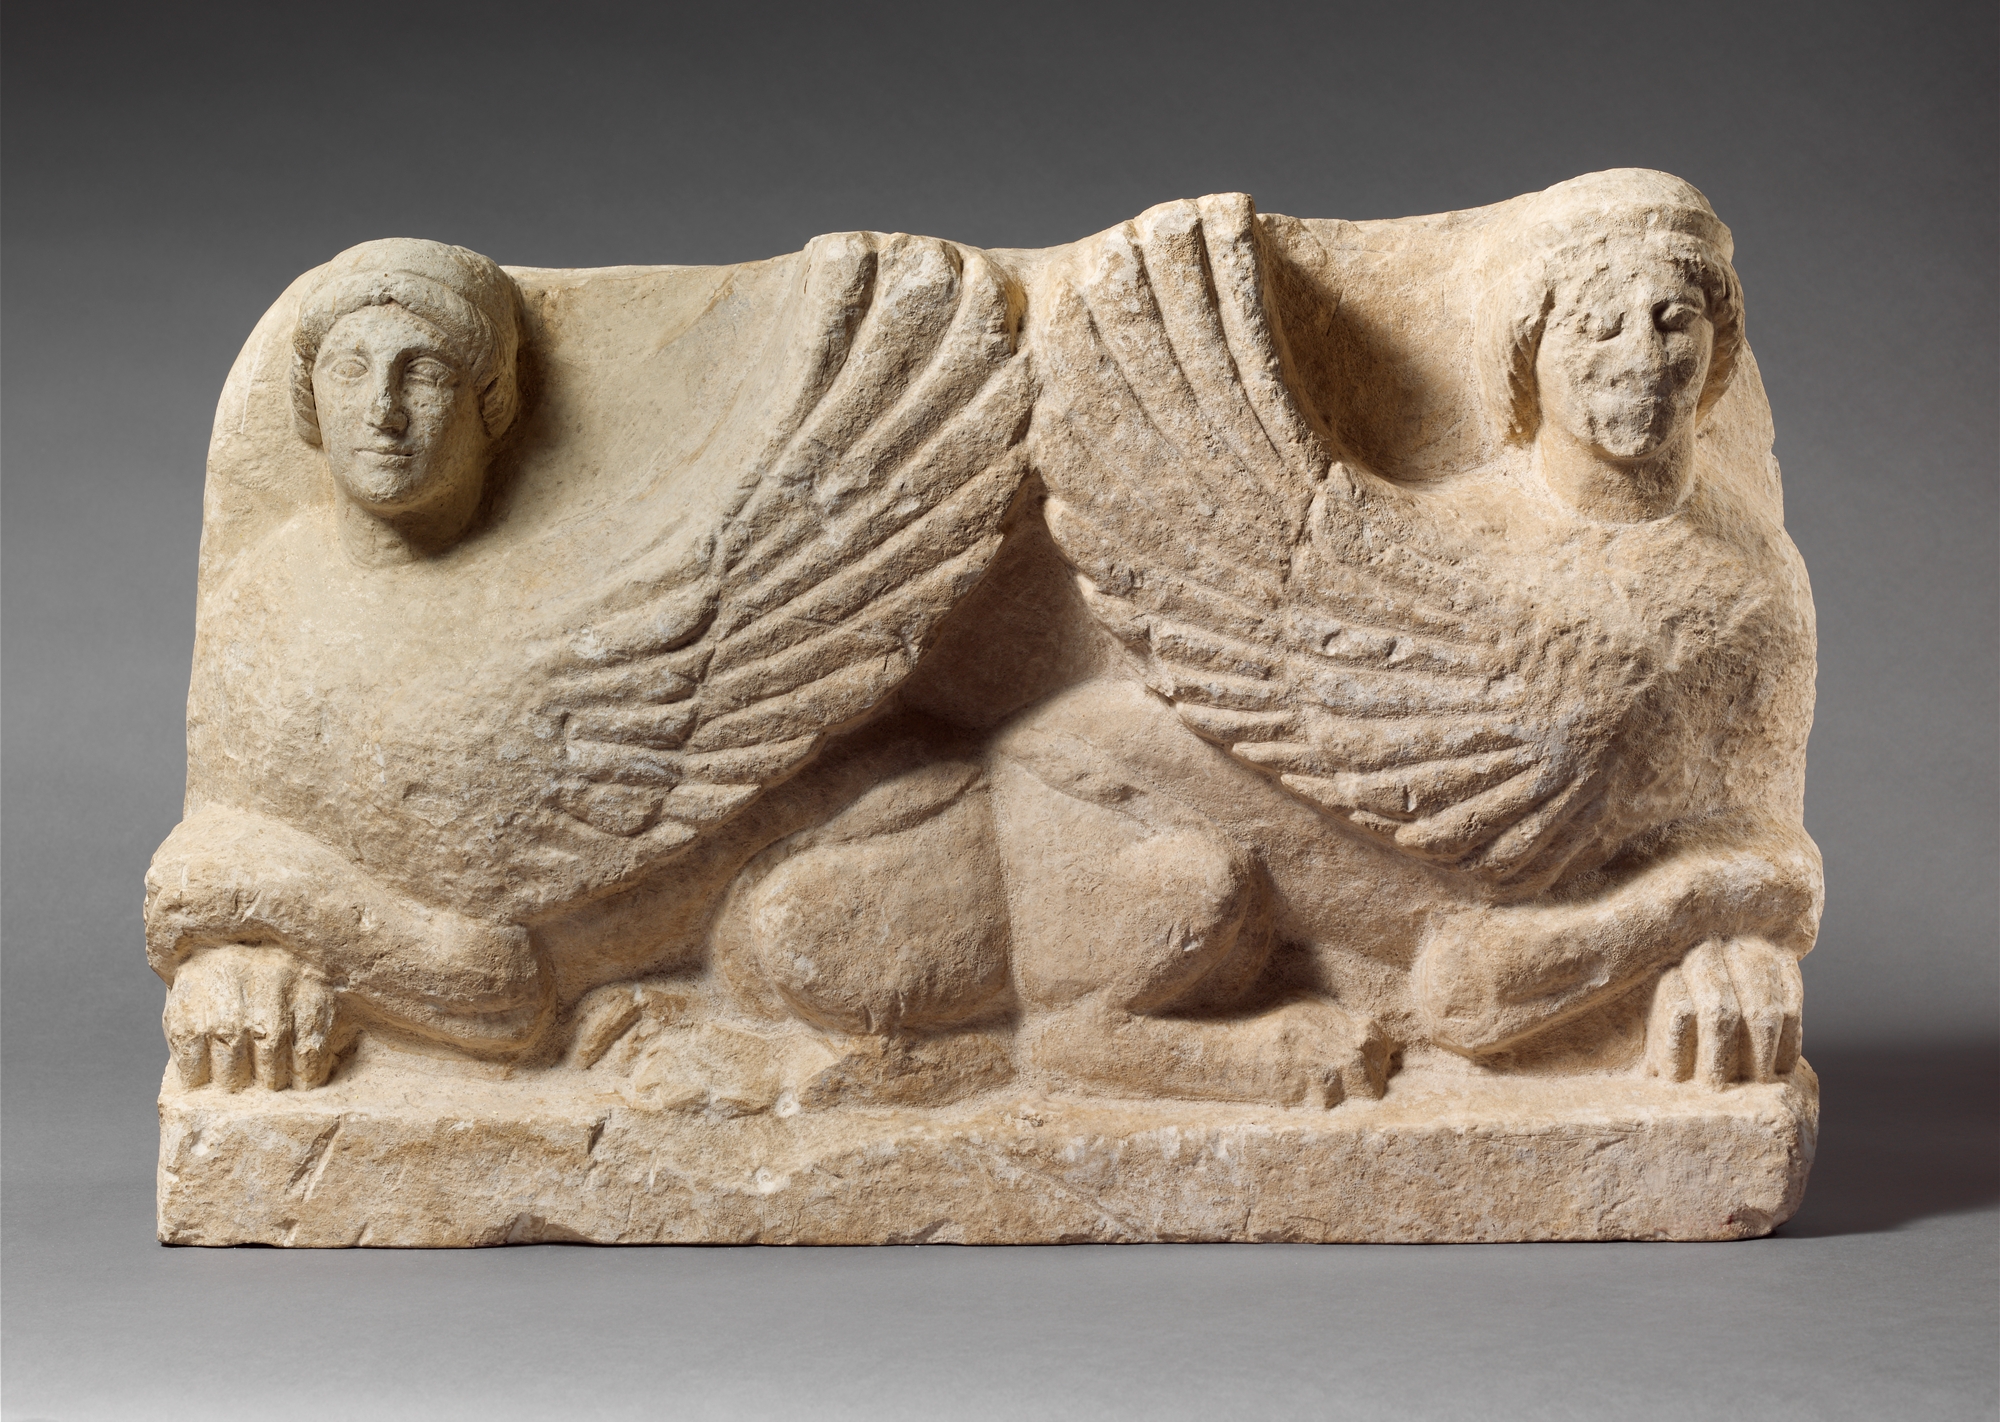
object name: grave relief with two sphinx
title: Limestone funerary stele with antithetical sphinxes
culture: cypriot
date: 475-450 BCE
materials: limestone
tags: sphinx